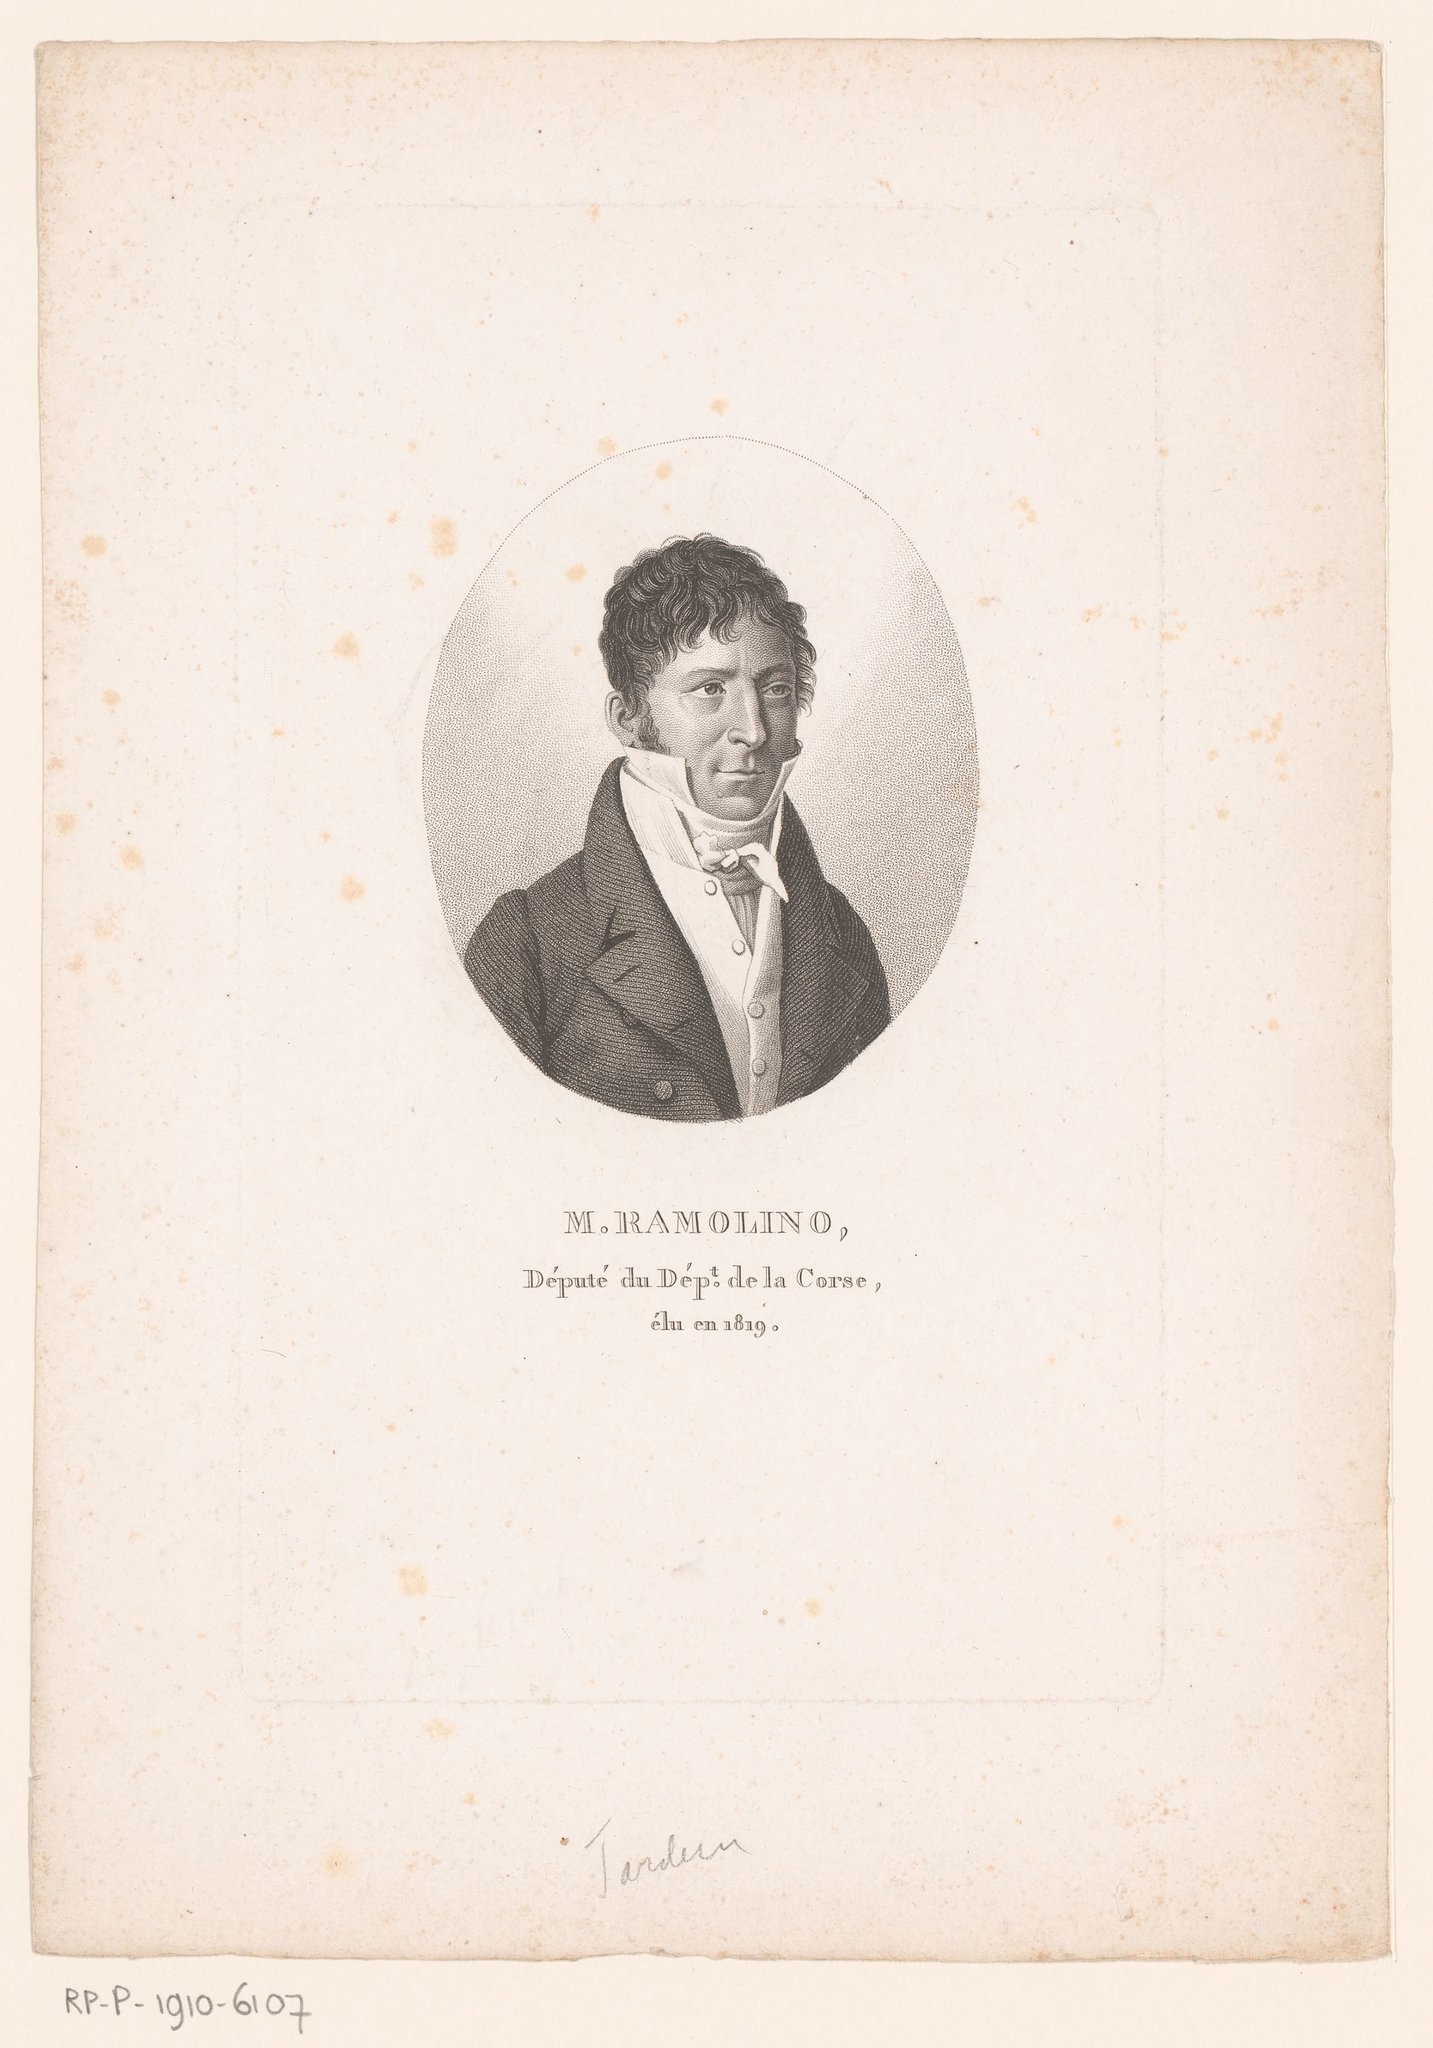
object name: print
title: Portret van André Ramolino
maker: ambroise tardieu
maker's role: print maker, printer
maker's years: 1788-1841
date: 1820-1821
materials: paper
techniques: engraving, roulette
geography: paris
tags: politician, historical persons, politician, e.g. party leader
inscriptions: collector's mark: Lugt 2228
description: Prent uit: Tardieu, Ambroise. Portraits des députés, écrivains et pairs constitutionnels, défenseurs invariables de la charte et de la loi des élections du 5 février 1817. Parijs: Tardieu, Ambroise, 1820-1821.